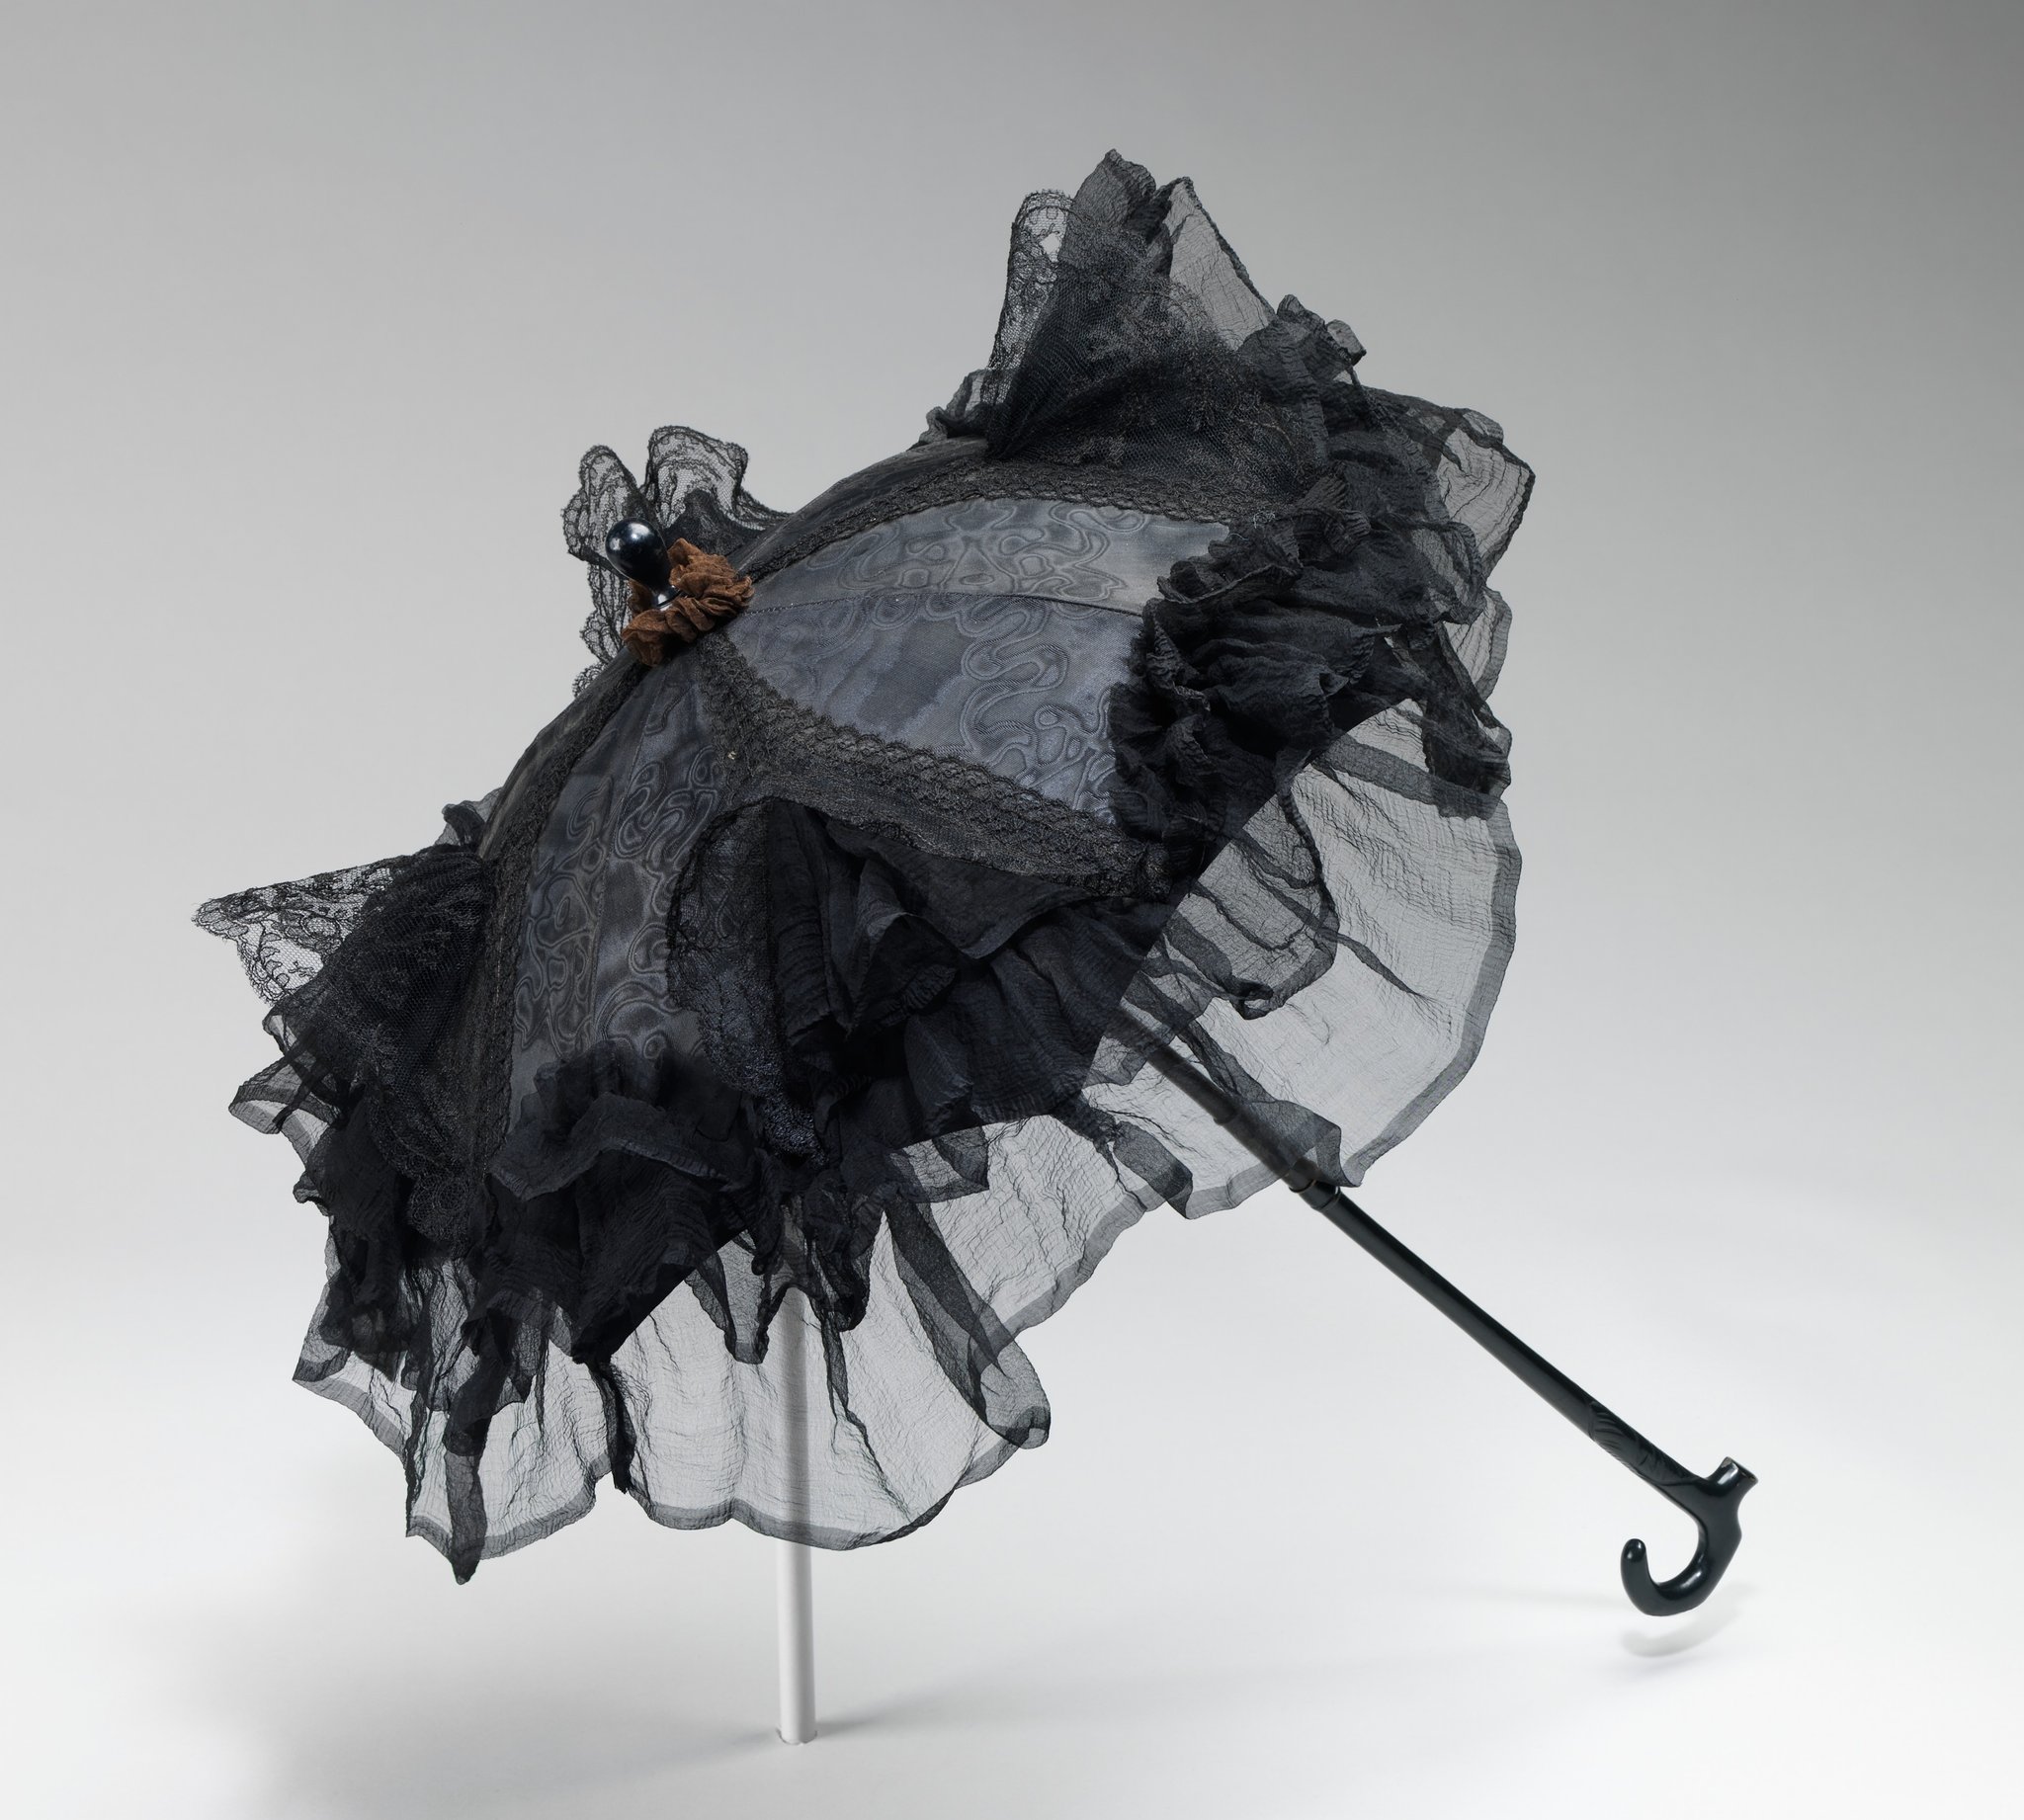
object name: parasol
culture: american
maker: stern brothers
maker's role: department store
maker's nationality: american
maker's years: 1867-2001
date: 1870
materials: metal, silk, wood